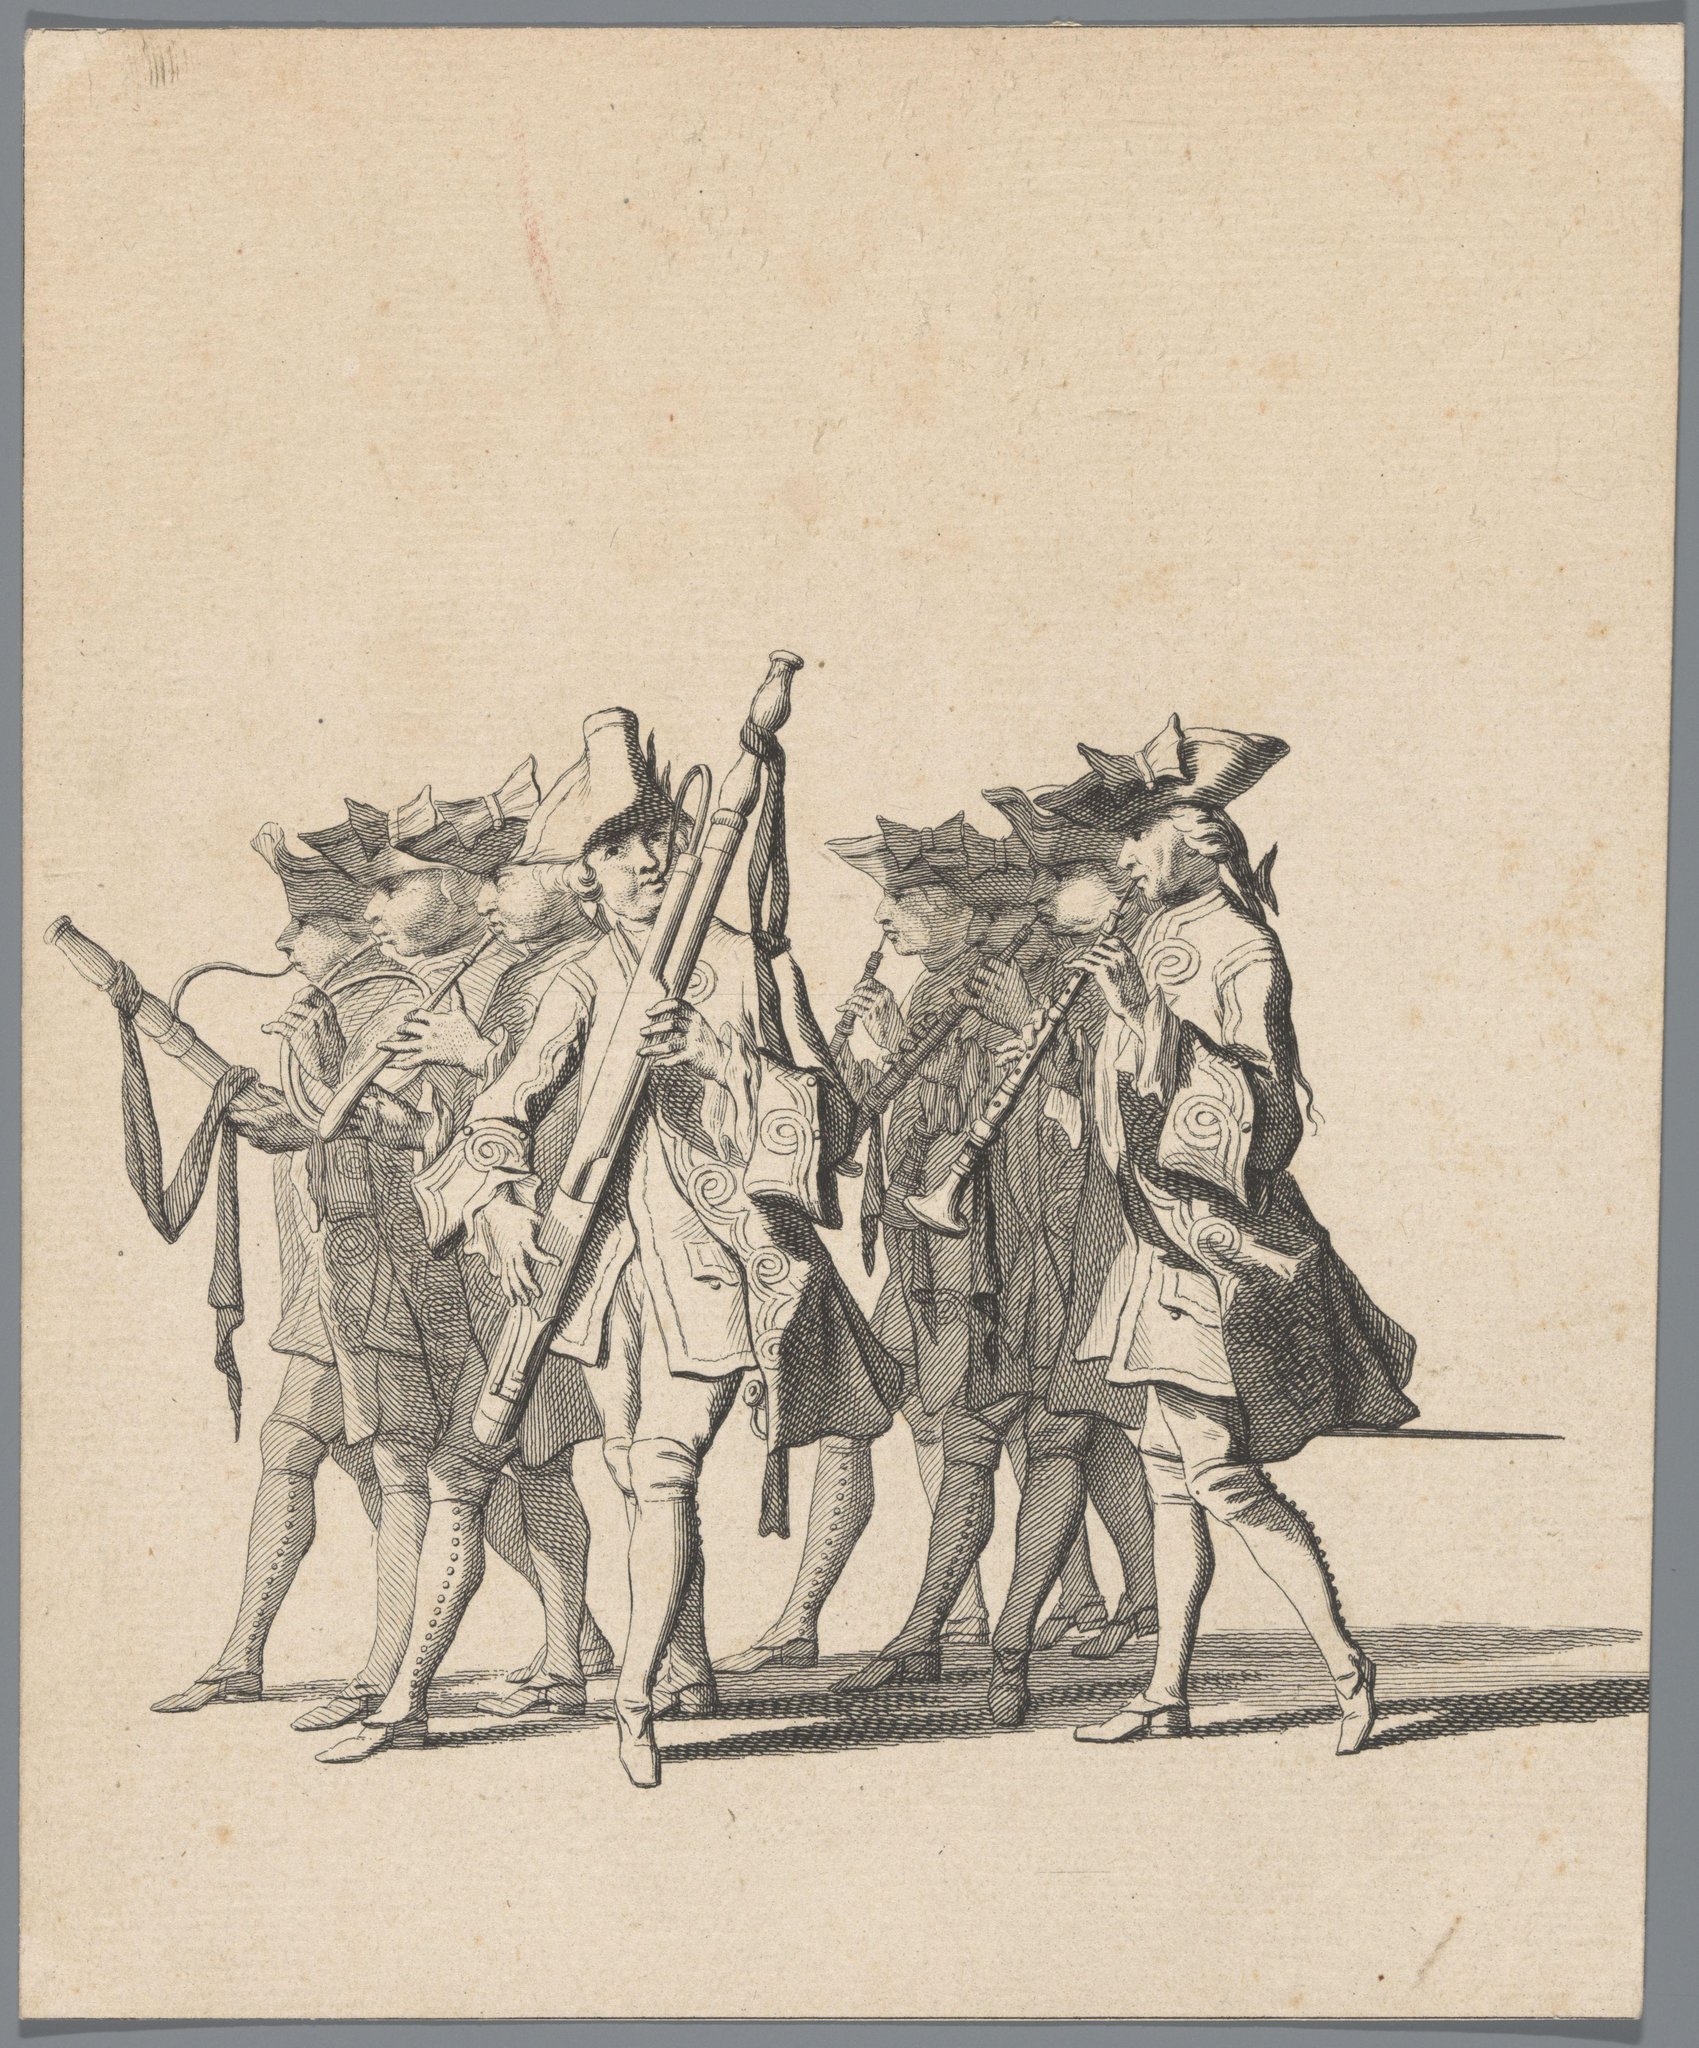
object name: print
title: Swiss Guards (Fragment from the Funeral Procession of William, 1752, Plate 5)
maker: jan punt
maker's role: draughtsman, print maker, publisher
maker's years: 1711-1779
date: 1752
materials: paper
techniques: engraving, etching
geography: northern netherlands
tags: the hague, willem iv (prins van oranje-nassau), military parade, pageant (+ infantry), military music, cortege, funeral procession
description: In the 17th and 18th centuries, the oboe was mostly played in bands for outdoor music. Originating in the army, oboe marching bands soon came to be adopted for civilian purposes. They played marches and dance suites, as well as processional and funeral music. Here we see a group of oboe players at Stadholder William IV’s funeral in Delft, 1752.